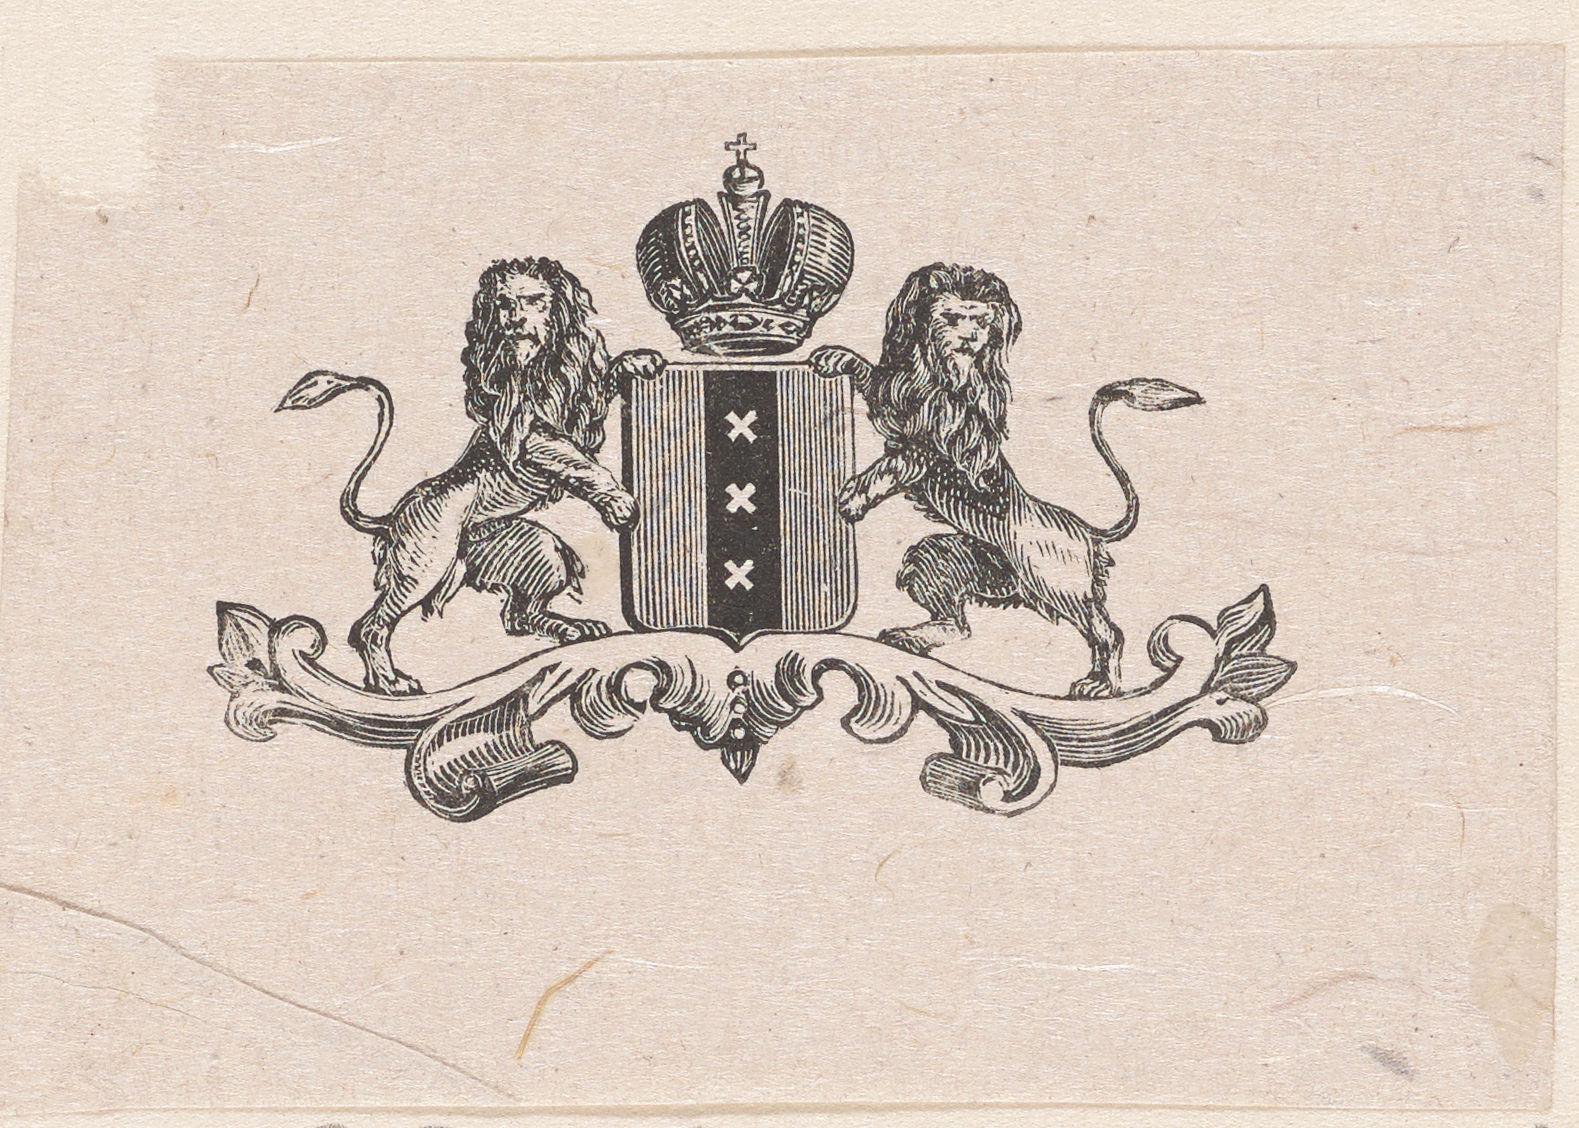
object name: print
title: Vignet met het wapen van de stad Amsterdam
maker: isaac weissenbruch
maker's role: print maker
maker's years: 1826-1912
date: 1836-1912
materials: paper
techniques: engraving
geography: netherlands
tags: coat of arms (as symbol of the state, etc.) (+ city; municipal), vignette, amsterdam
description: Het wapen van de stad Amsterdam met een kroon, twee leeuwen en drie Andreaskruisen.